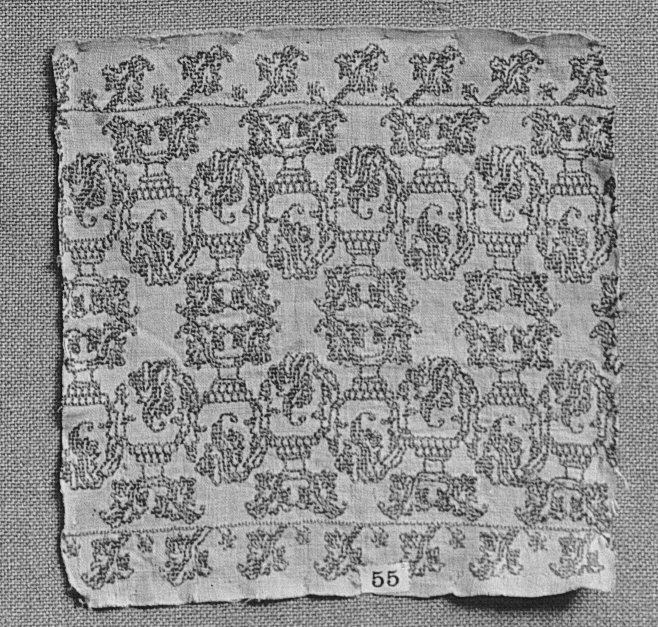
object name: fragment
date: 1601-1700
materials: linen, silk